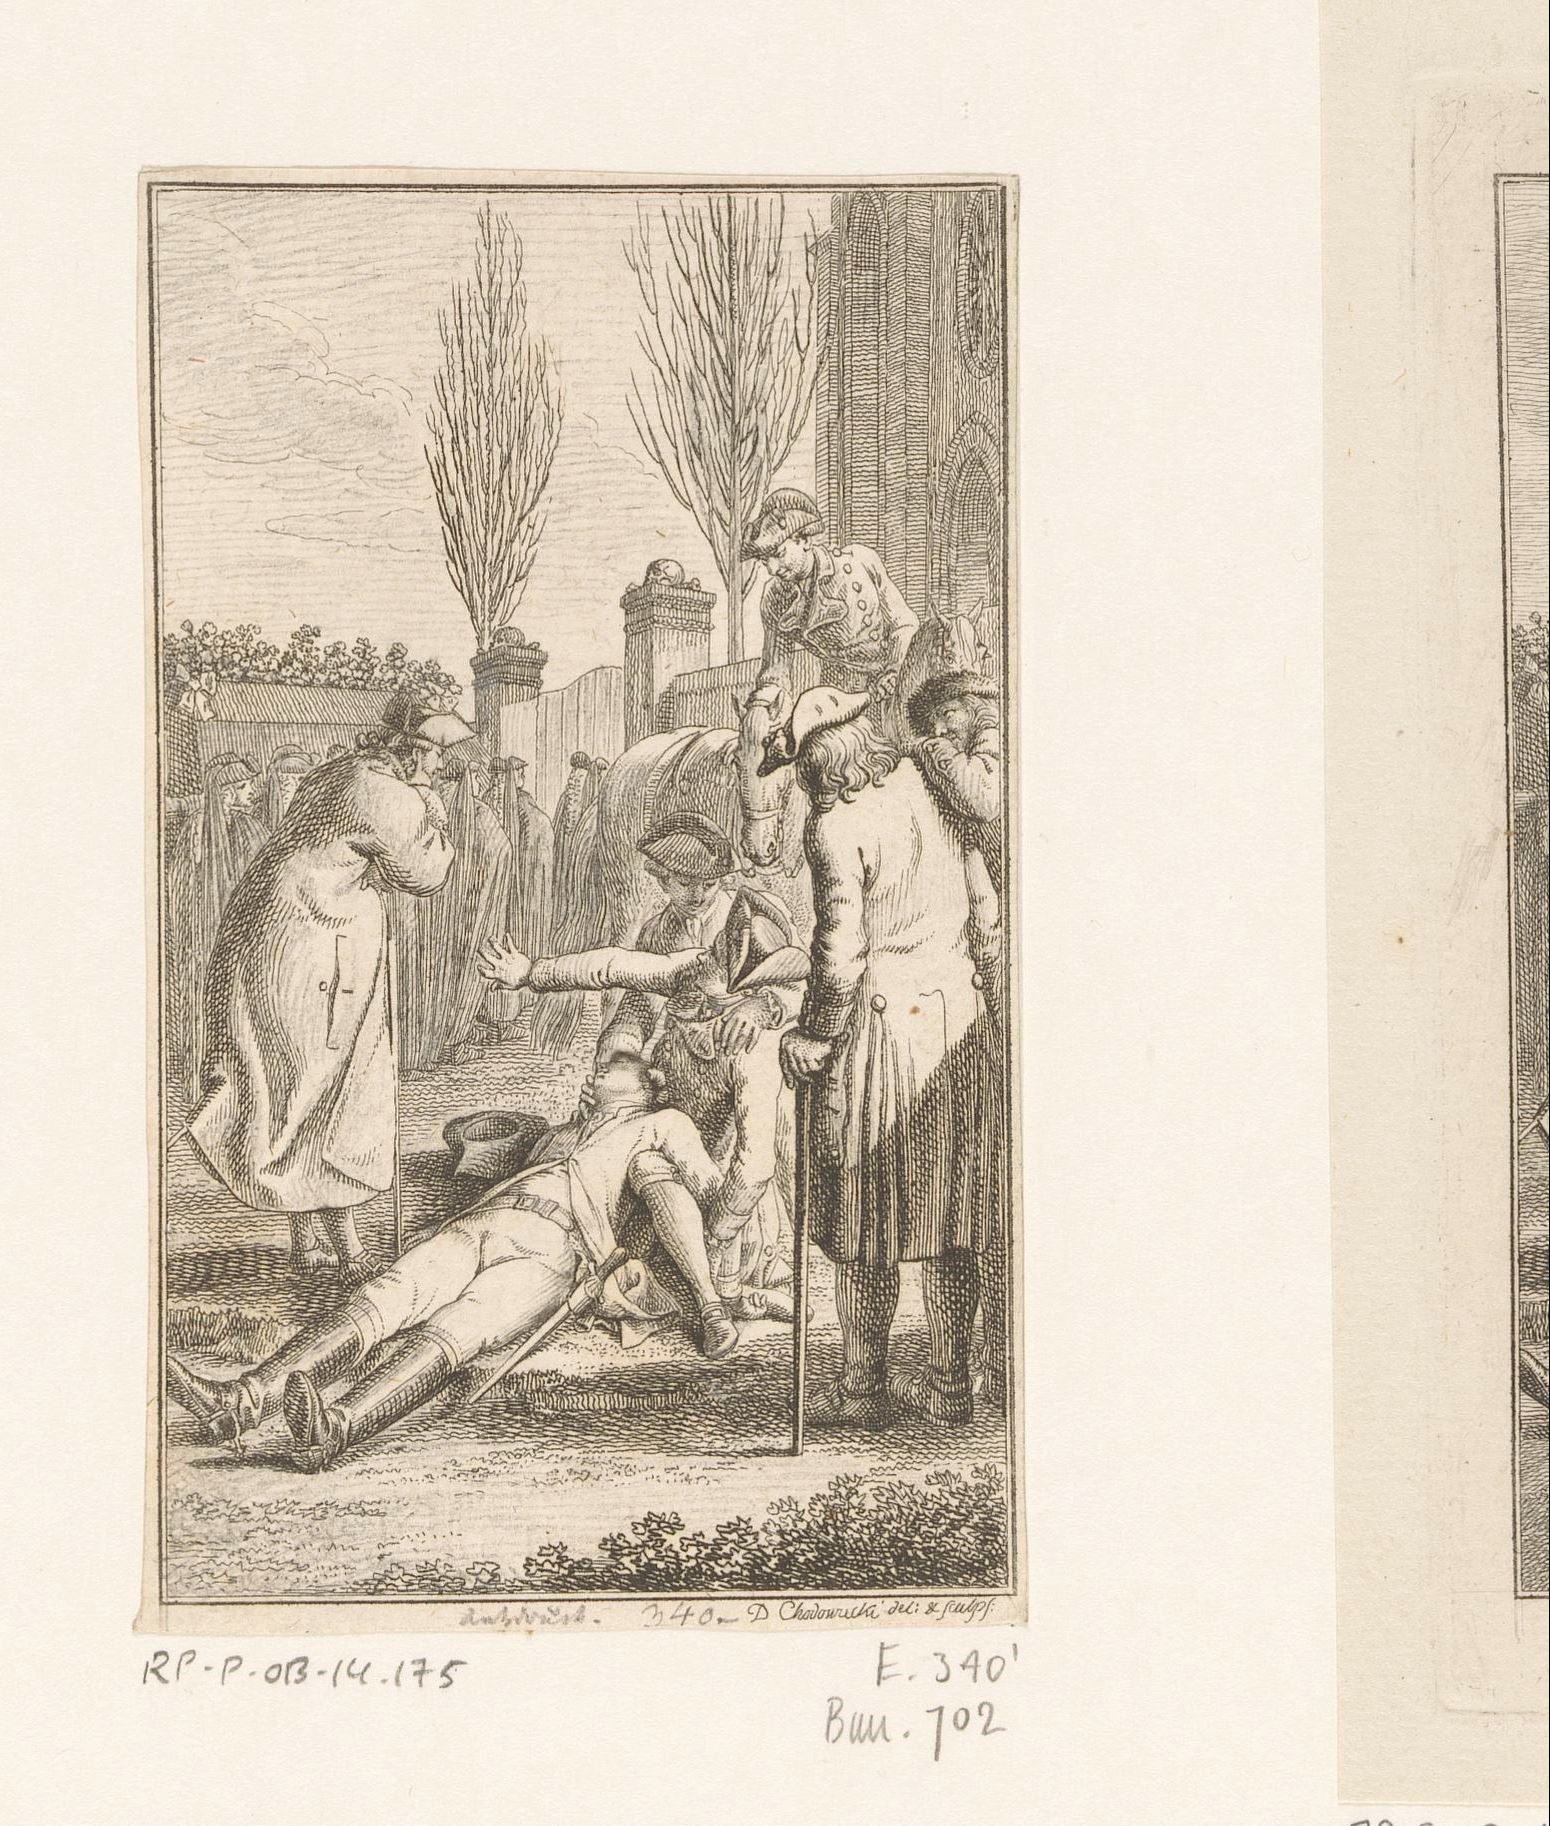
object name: print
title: Brückner bewusteloos op de grond na het zien van de begrafenisstoet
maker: daniel nikolaus chodowiecki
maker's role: draughtsman, print maker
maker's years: 1726-1801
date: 1780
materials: paper, pencil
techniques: etching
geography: berlin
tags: literature, cortege, funeral procession, fainting, swooning - bb - out of doors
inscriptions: inscription: ‘aufcorrigi[r]te Aetzdrück’, collector's mark: Lugt 2228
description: Brückner, die enige tijd afwezig is geweest om steun te verwerven voor zijn huwelijk met Steinnin, ziet bij terugkomst een begrafenisstoet voorbijtrekken. Hij informeert bij zijn vriend Wilhelm wie er is overleden en valt van schrik van zijn paard als blijkt dat het de begrafenis van zijn verloofde betreft. Brückner ligt bewusteloos in de armen van Wilhelm; in de achtergrond de begrafenisstoet met de kist met het lichaam van Steinnin. Rechtsboven genummerd: 79 S.